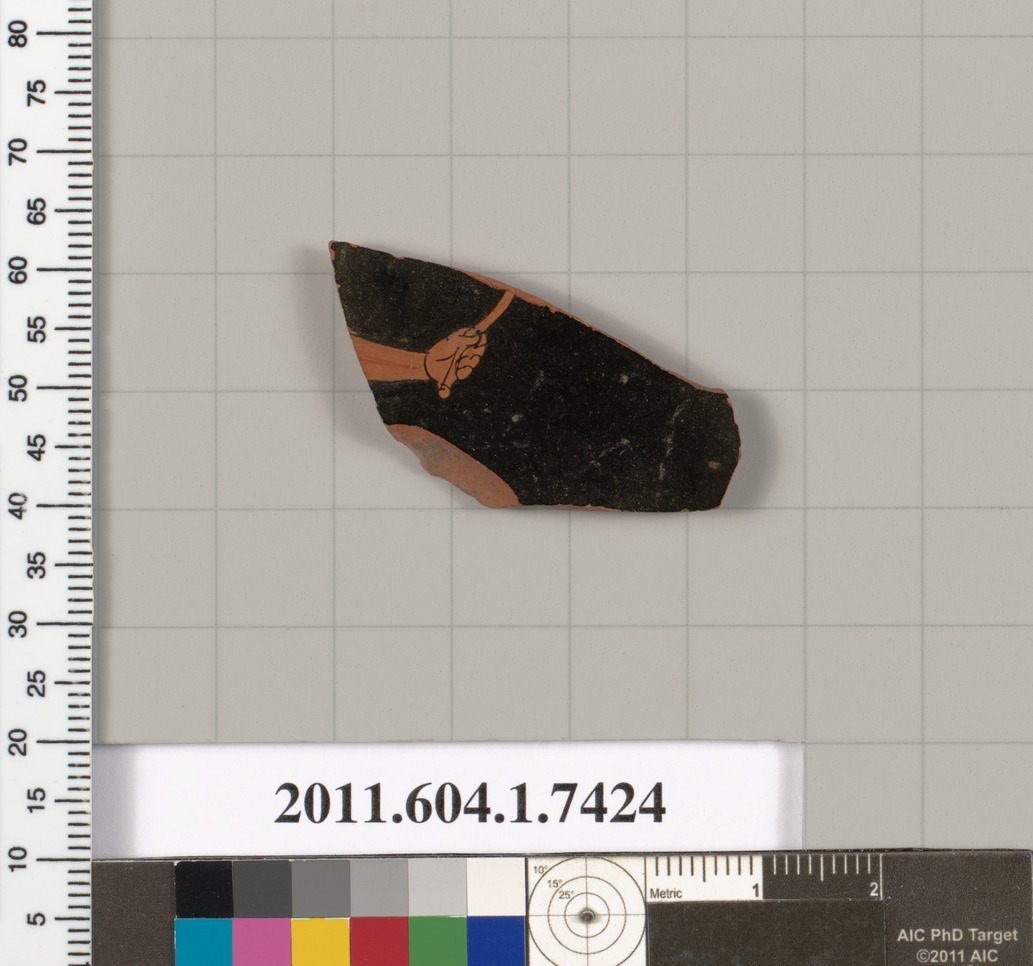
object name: kylix fragment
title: Terracotta fragment of a kylix (drinking cup)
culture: greek, attic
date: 490-470 BCE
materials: terracotta